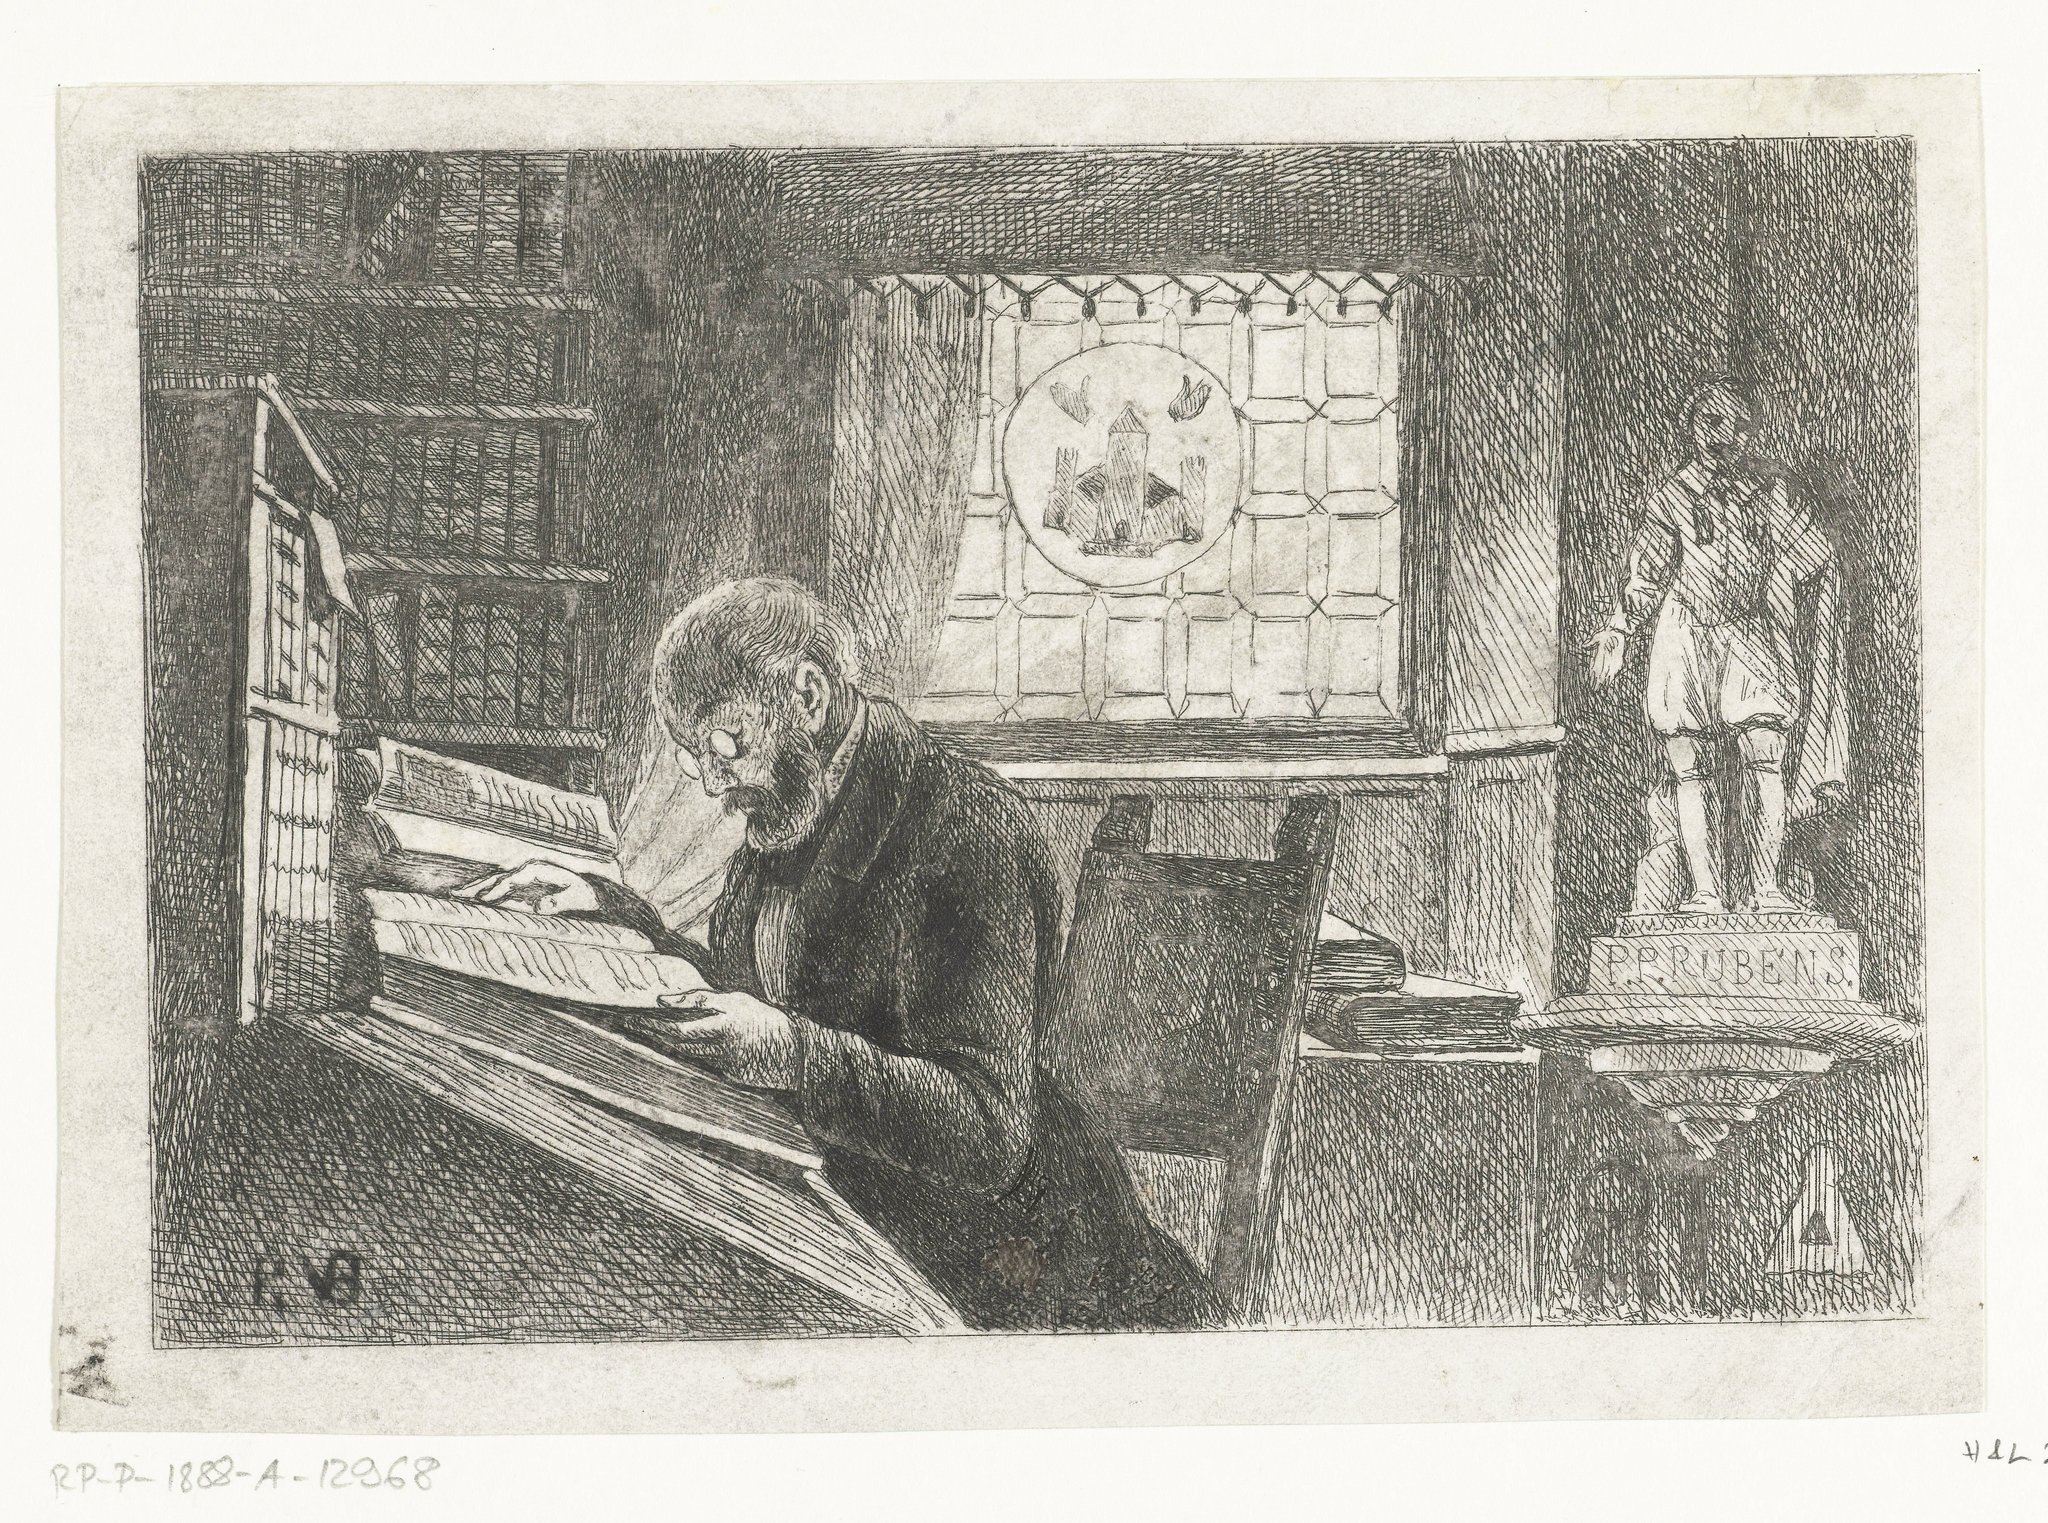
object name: print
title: Portret van Frederik Verachter aan zijn bureau in het archief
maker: philippus jacobus van bree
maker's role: draughtsman, print maker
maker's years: 1786-1871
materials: paper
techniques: etching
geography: antwerp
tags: historical persons, archive (+ scholar, scientist (at work)), armorial bearing, heraldry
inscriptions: collector's mark: Lugt 2228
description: Portret van de Antwerpse stadsarchivaris Frederik Verachter, zittend aan zijn bureau in het archief. Rechts in de hoek staat een beeld van Rubens op een tafel. In het glas-in-lood van het raam zit het wapen van de stad Antwerpen verwerkt.